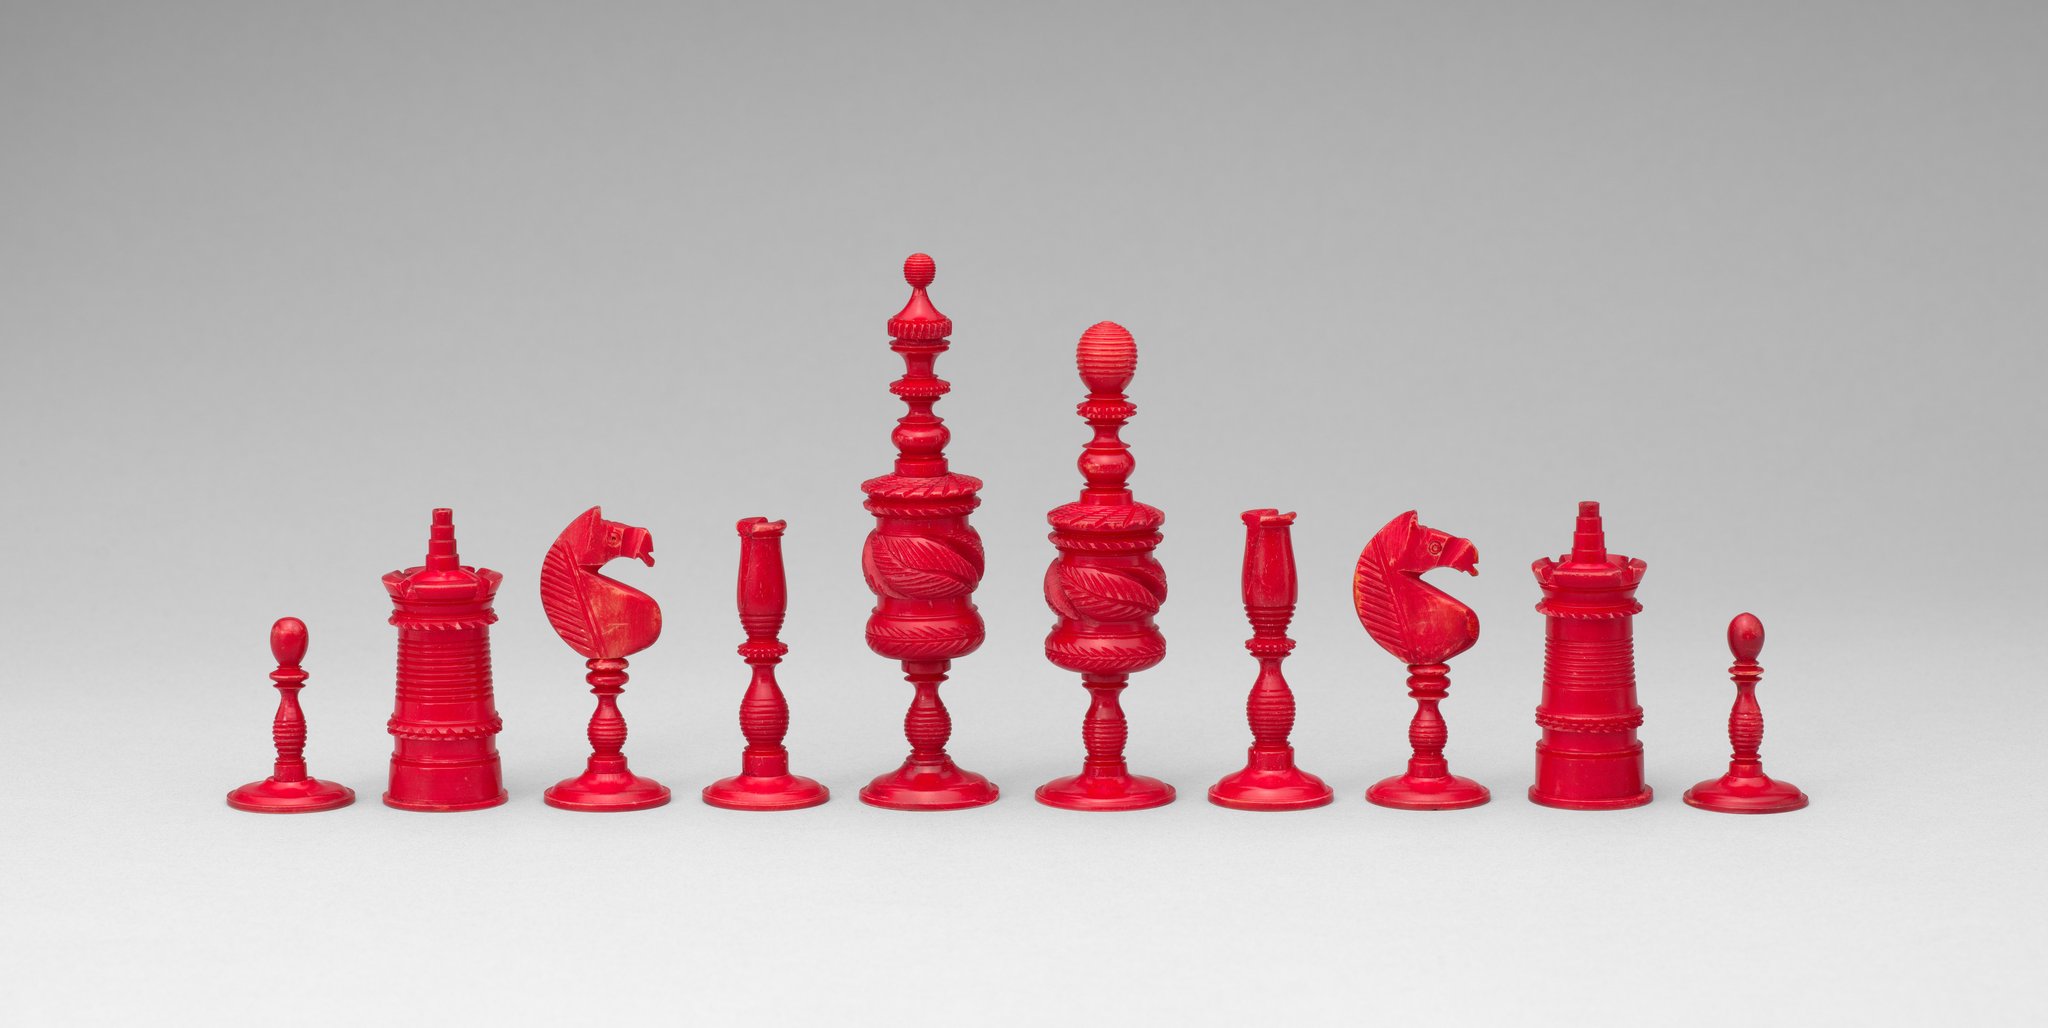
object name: chessman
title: Chessmen (32)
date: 1801-1833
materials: bone